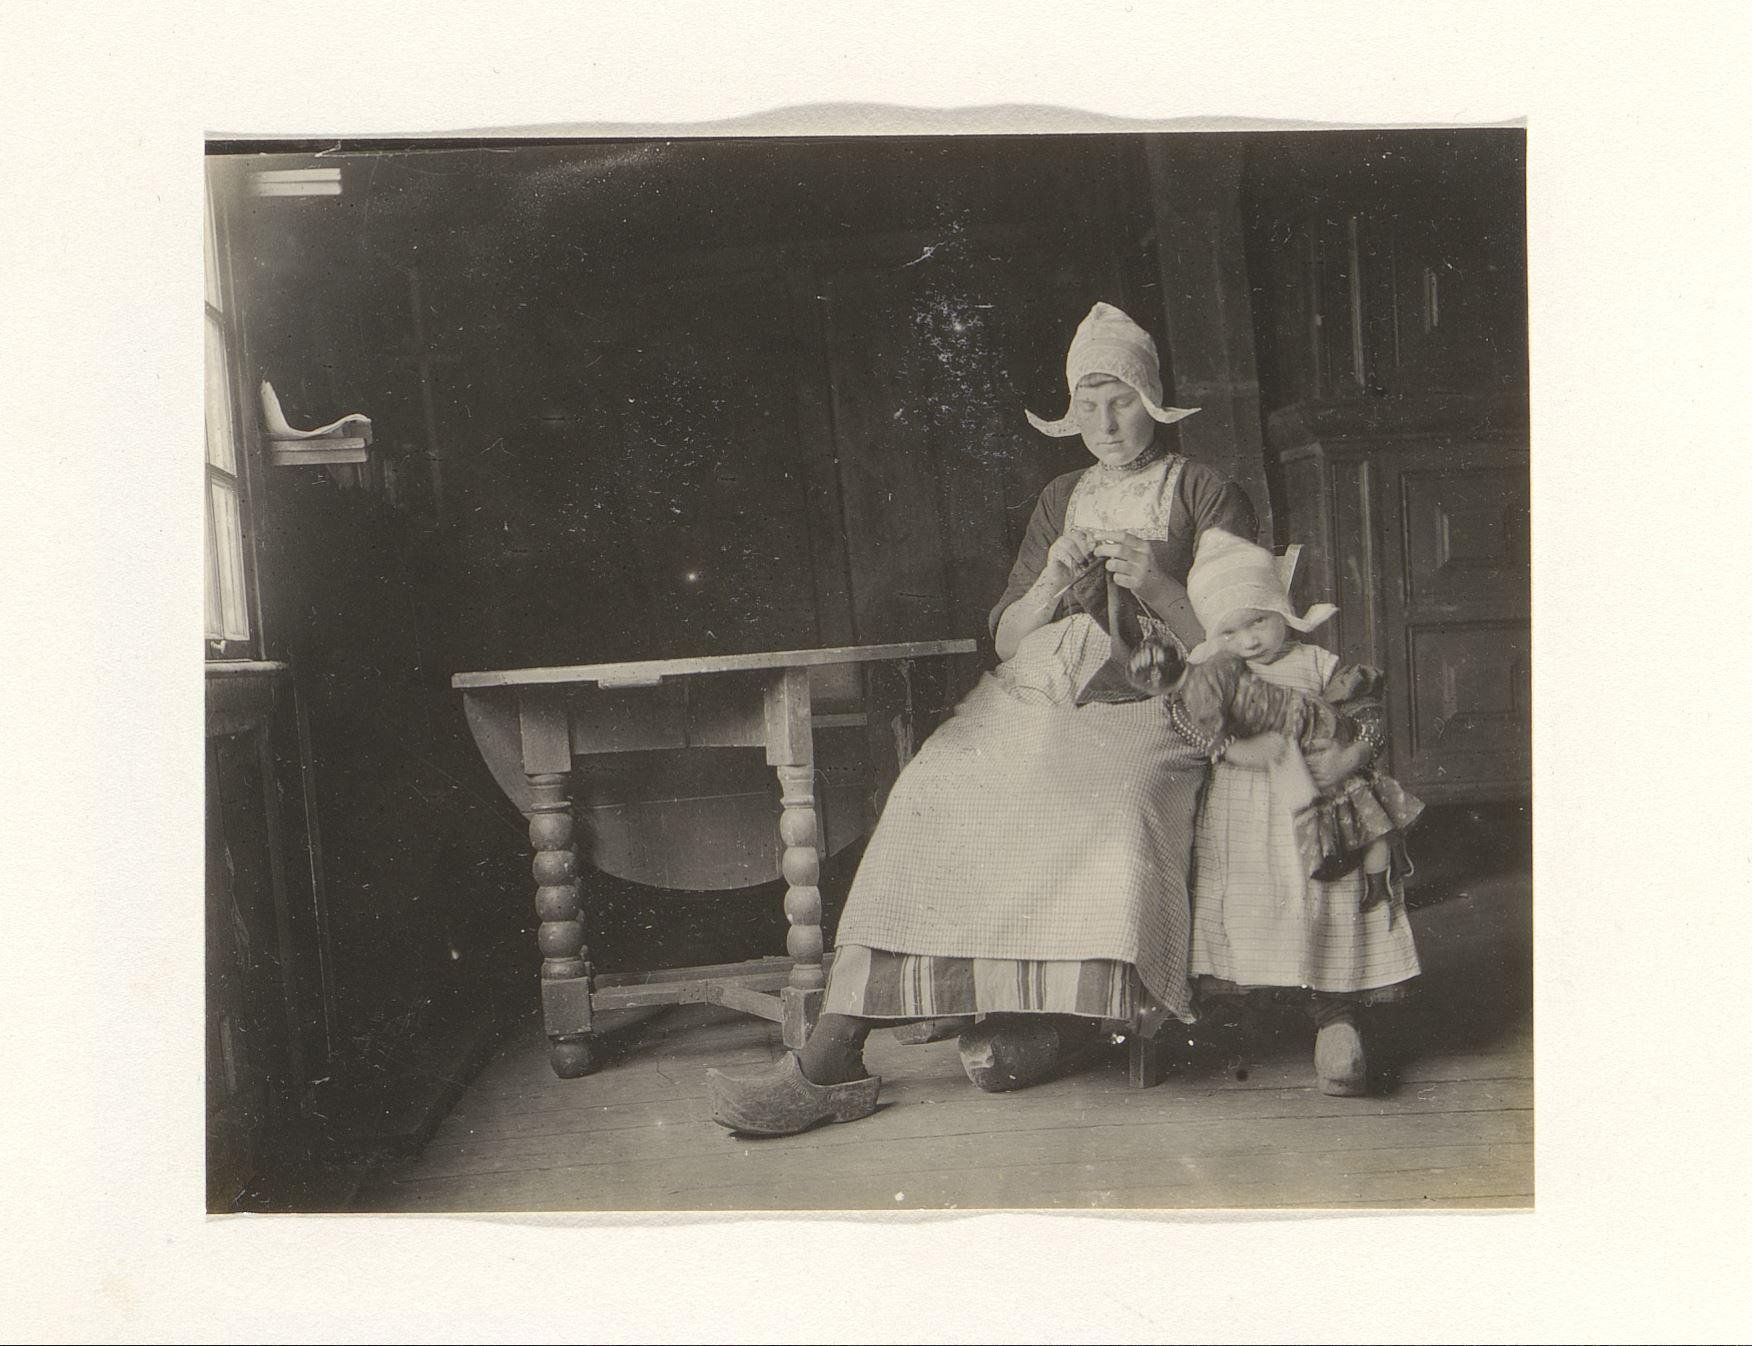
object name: photograph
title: Breiende vrouw met kind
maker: george hidderley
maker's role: fotograaf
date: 1900-1910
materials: paper, photographic support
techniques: gelatin silver print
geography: volendam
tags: historical persons, interior of the house, knitting, mother and child(ren), woman and child(ren) (family group)